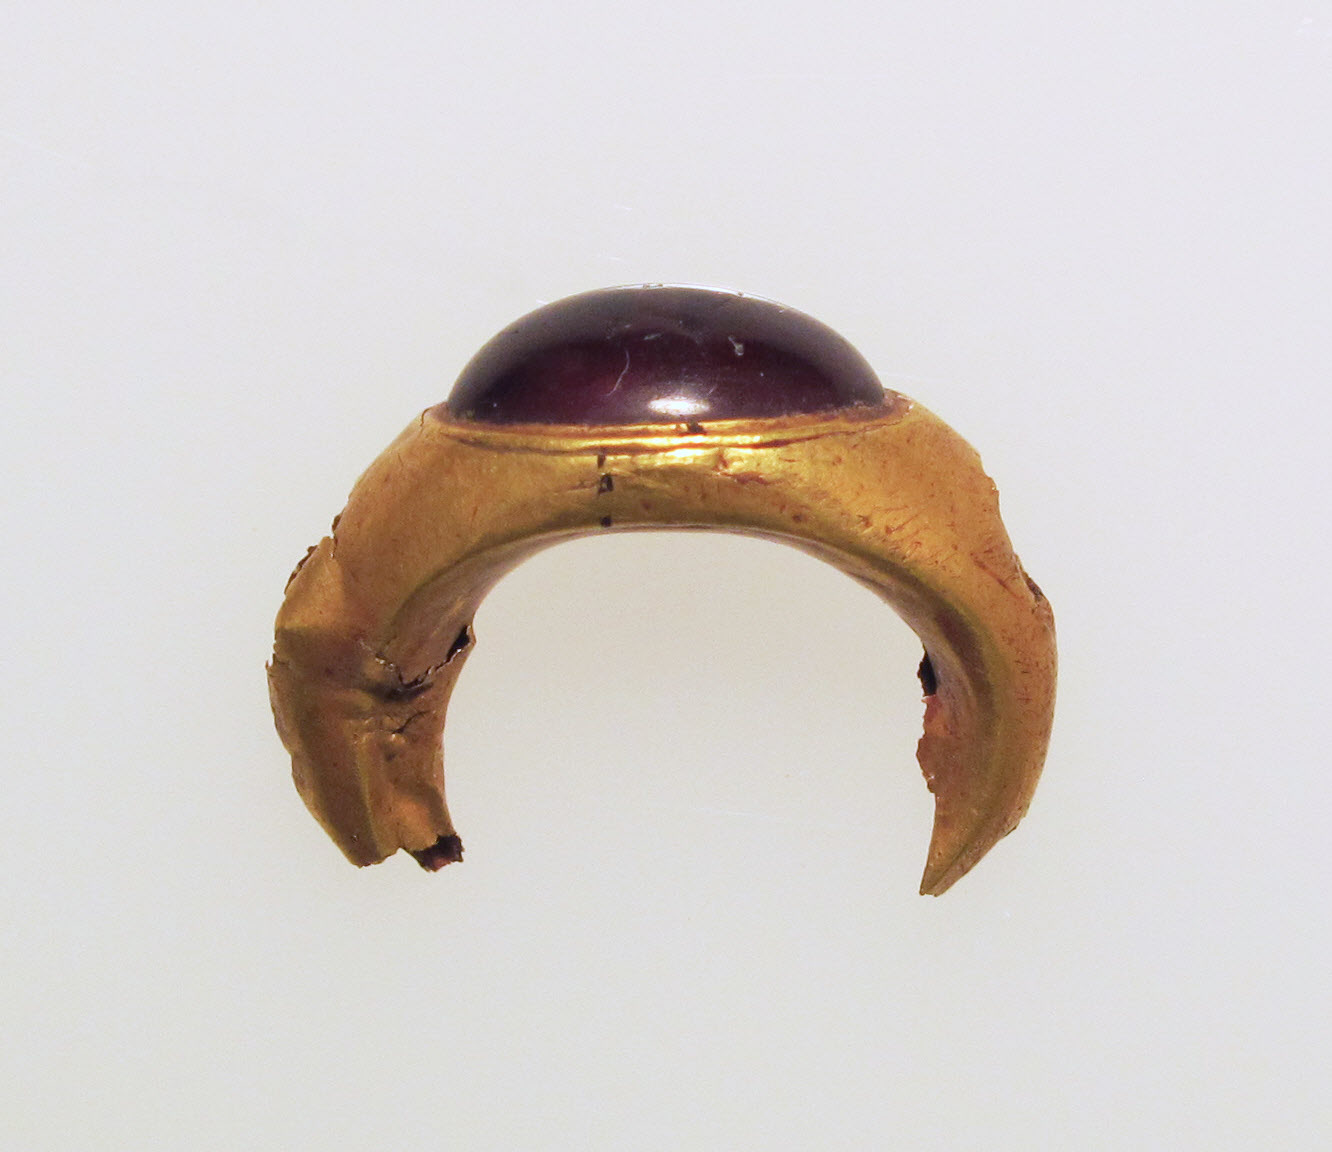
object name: ring with carbuncle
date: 7000 BCE-330 CE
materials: gold